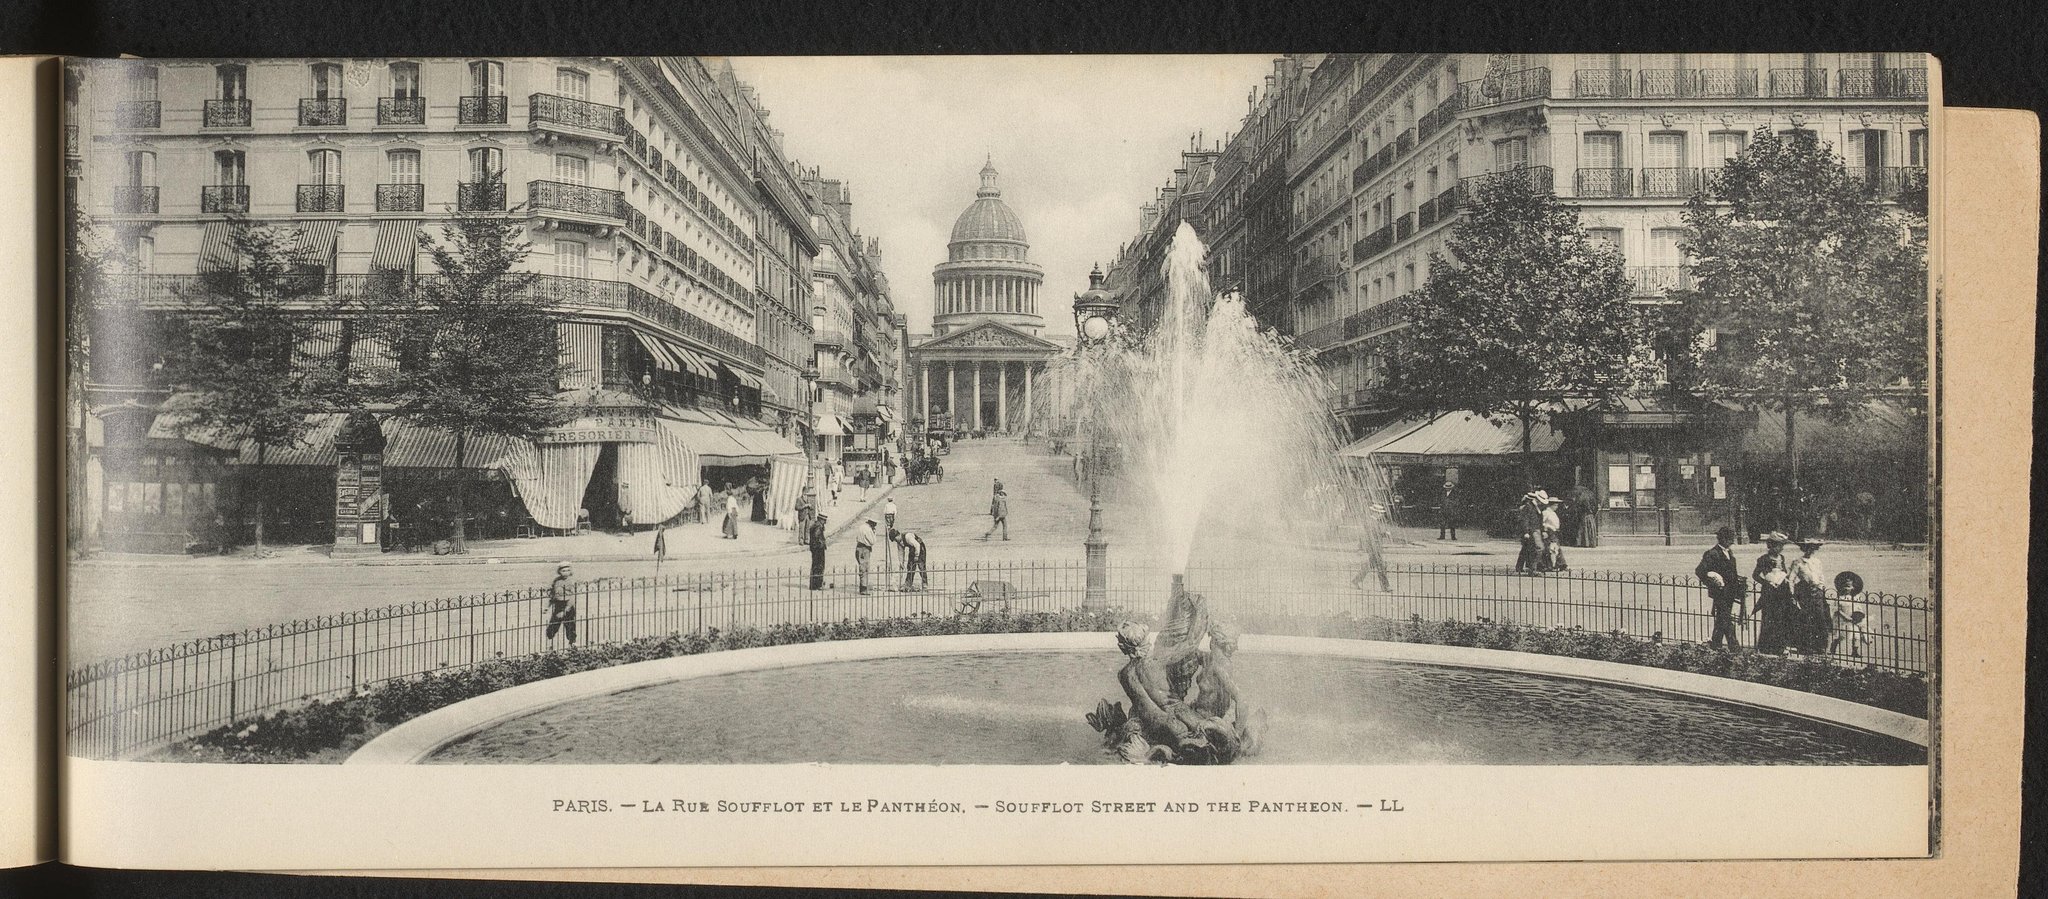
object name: photomechanical print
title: Paris. La Rue Soufflot et le Panthéon / Soufflot Street and the Pantheon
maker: Anonymous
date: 1920-1932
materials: cardboard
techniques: photograph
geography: paris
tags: church (exterior), square, place, circus, etc. (+ city(-scape) with figures, staffage), ornamental fountain (+ city(-scape) with figures, staffage)